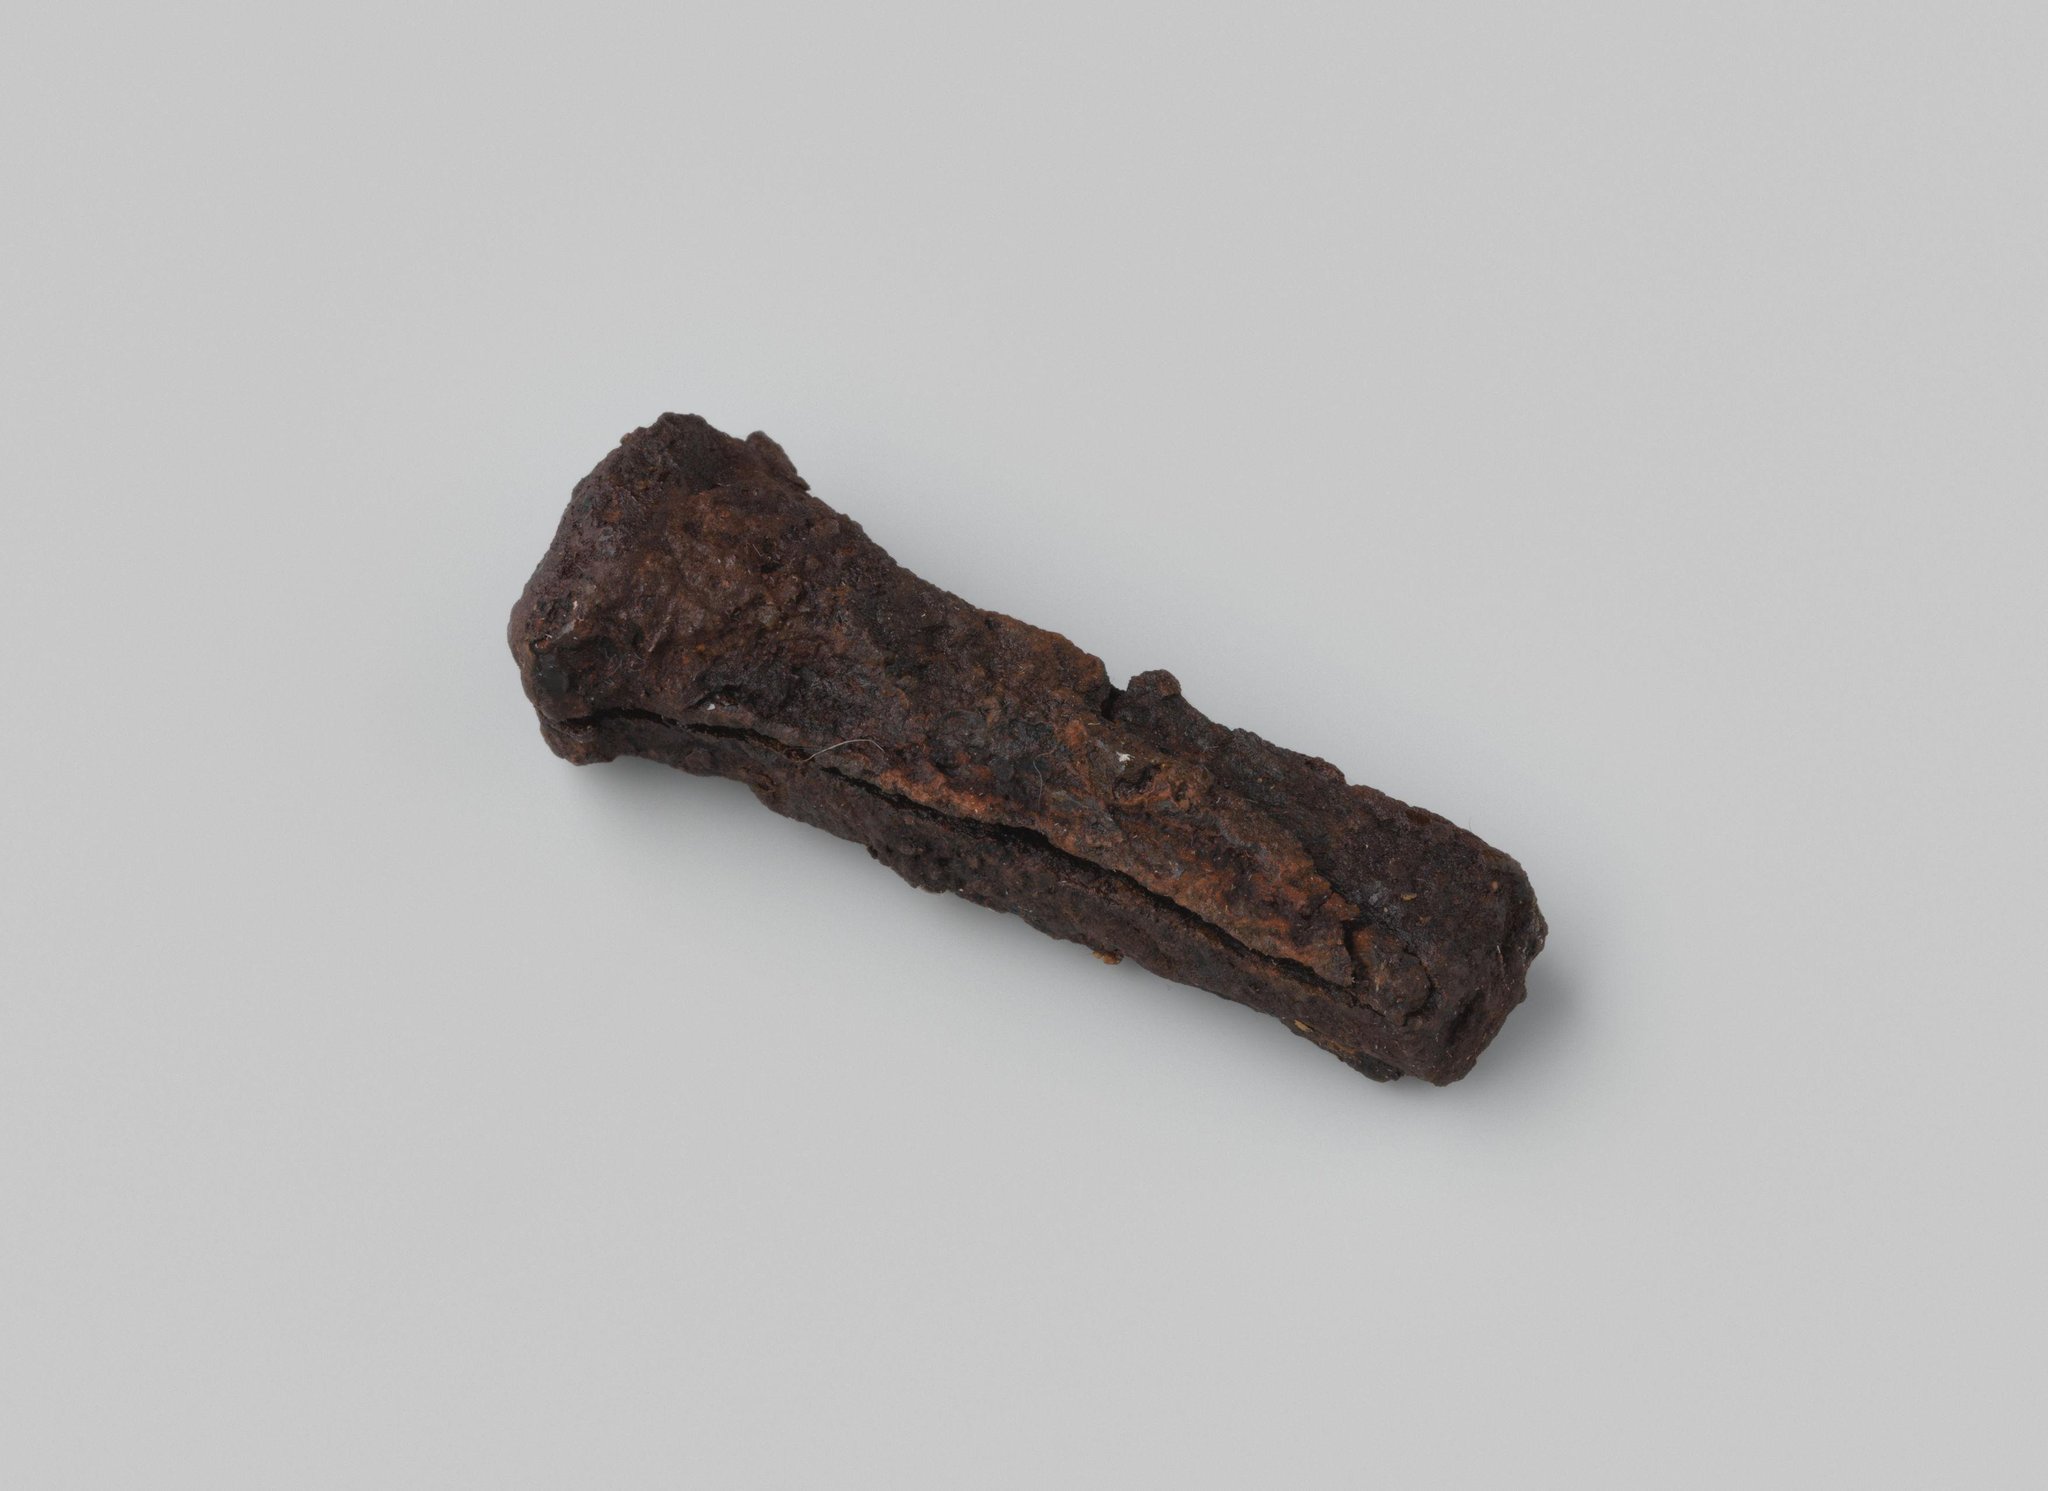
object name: nagel, spijker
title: Spijker afkomstig uit het wrak van de Oost-Indiëvaarder Hollandia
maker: Anonymous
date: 1700-1743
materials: iron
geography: netherlands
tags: verenigde oostindische compagnie, hollandia (schip)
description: Nails; fragm of shaft, head, sim. 80H2439, corroded.